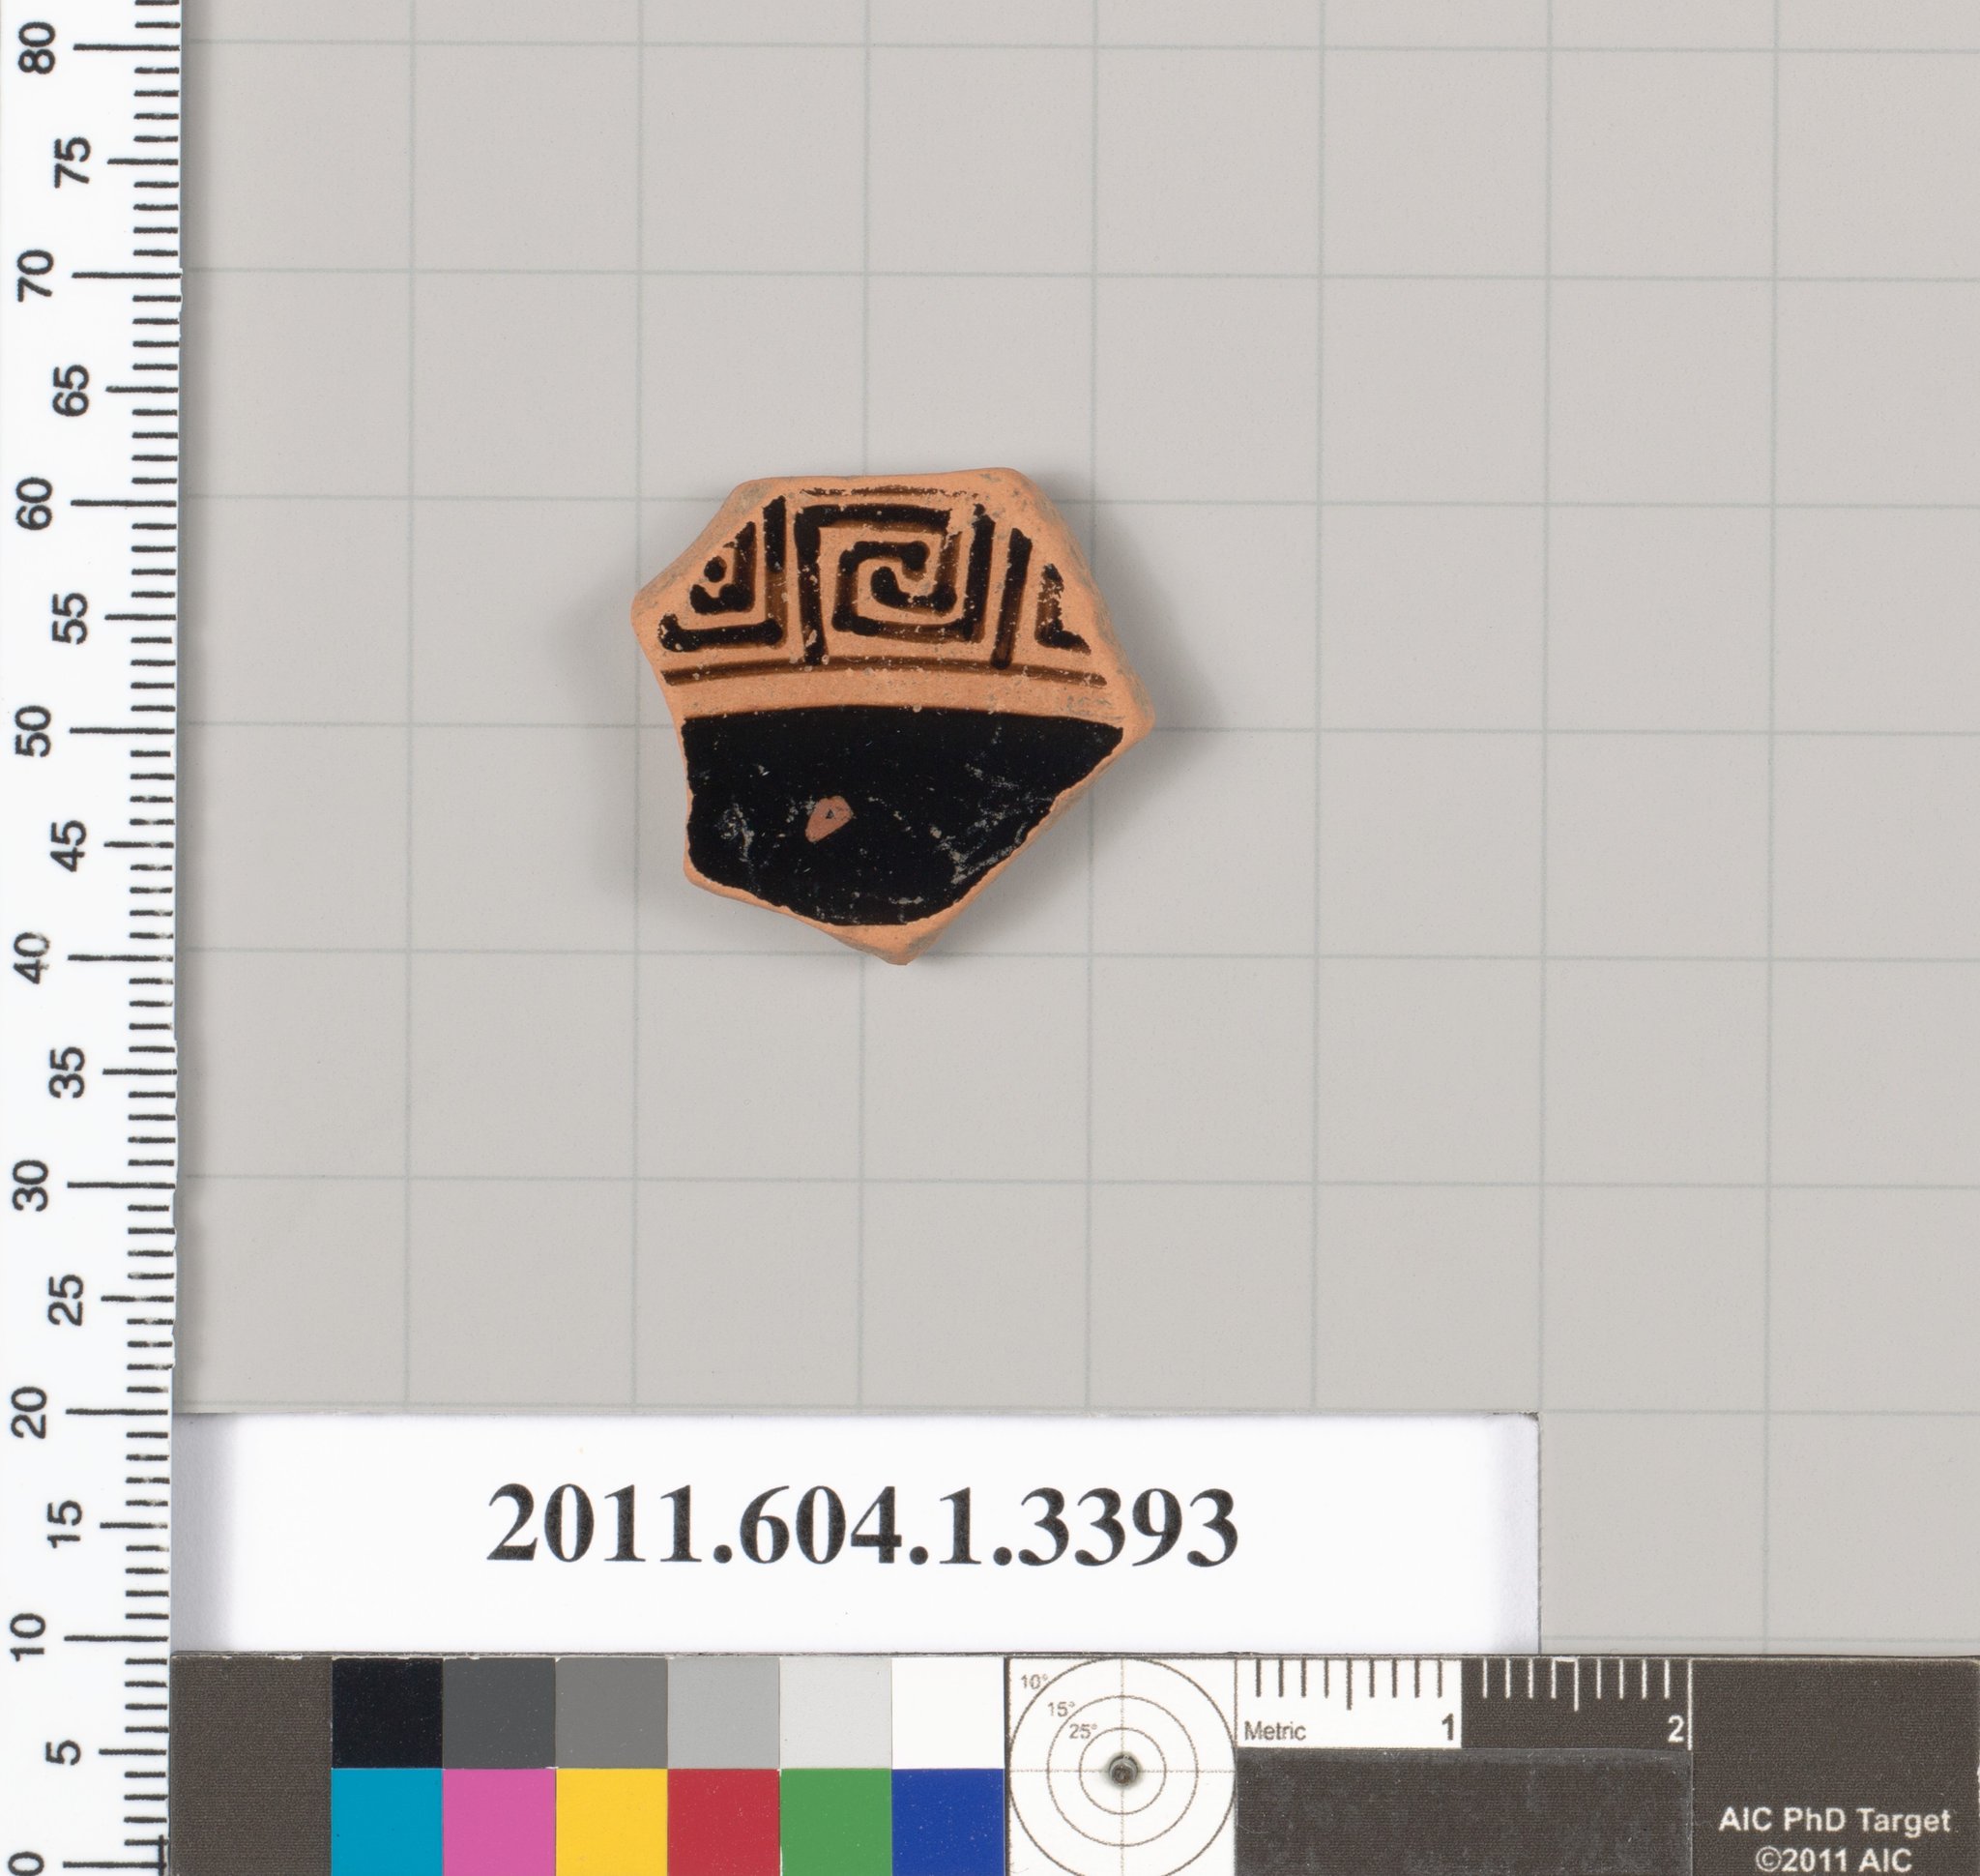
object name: kylix fragment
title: Terracotta fragment of a kylix (drinking cup)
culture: greek, attic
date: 490-470 BCE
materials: terracotta